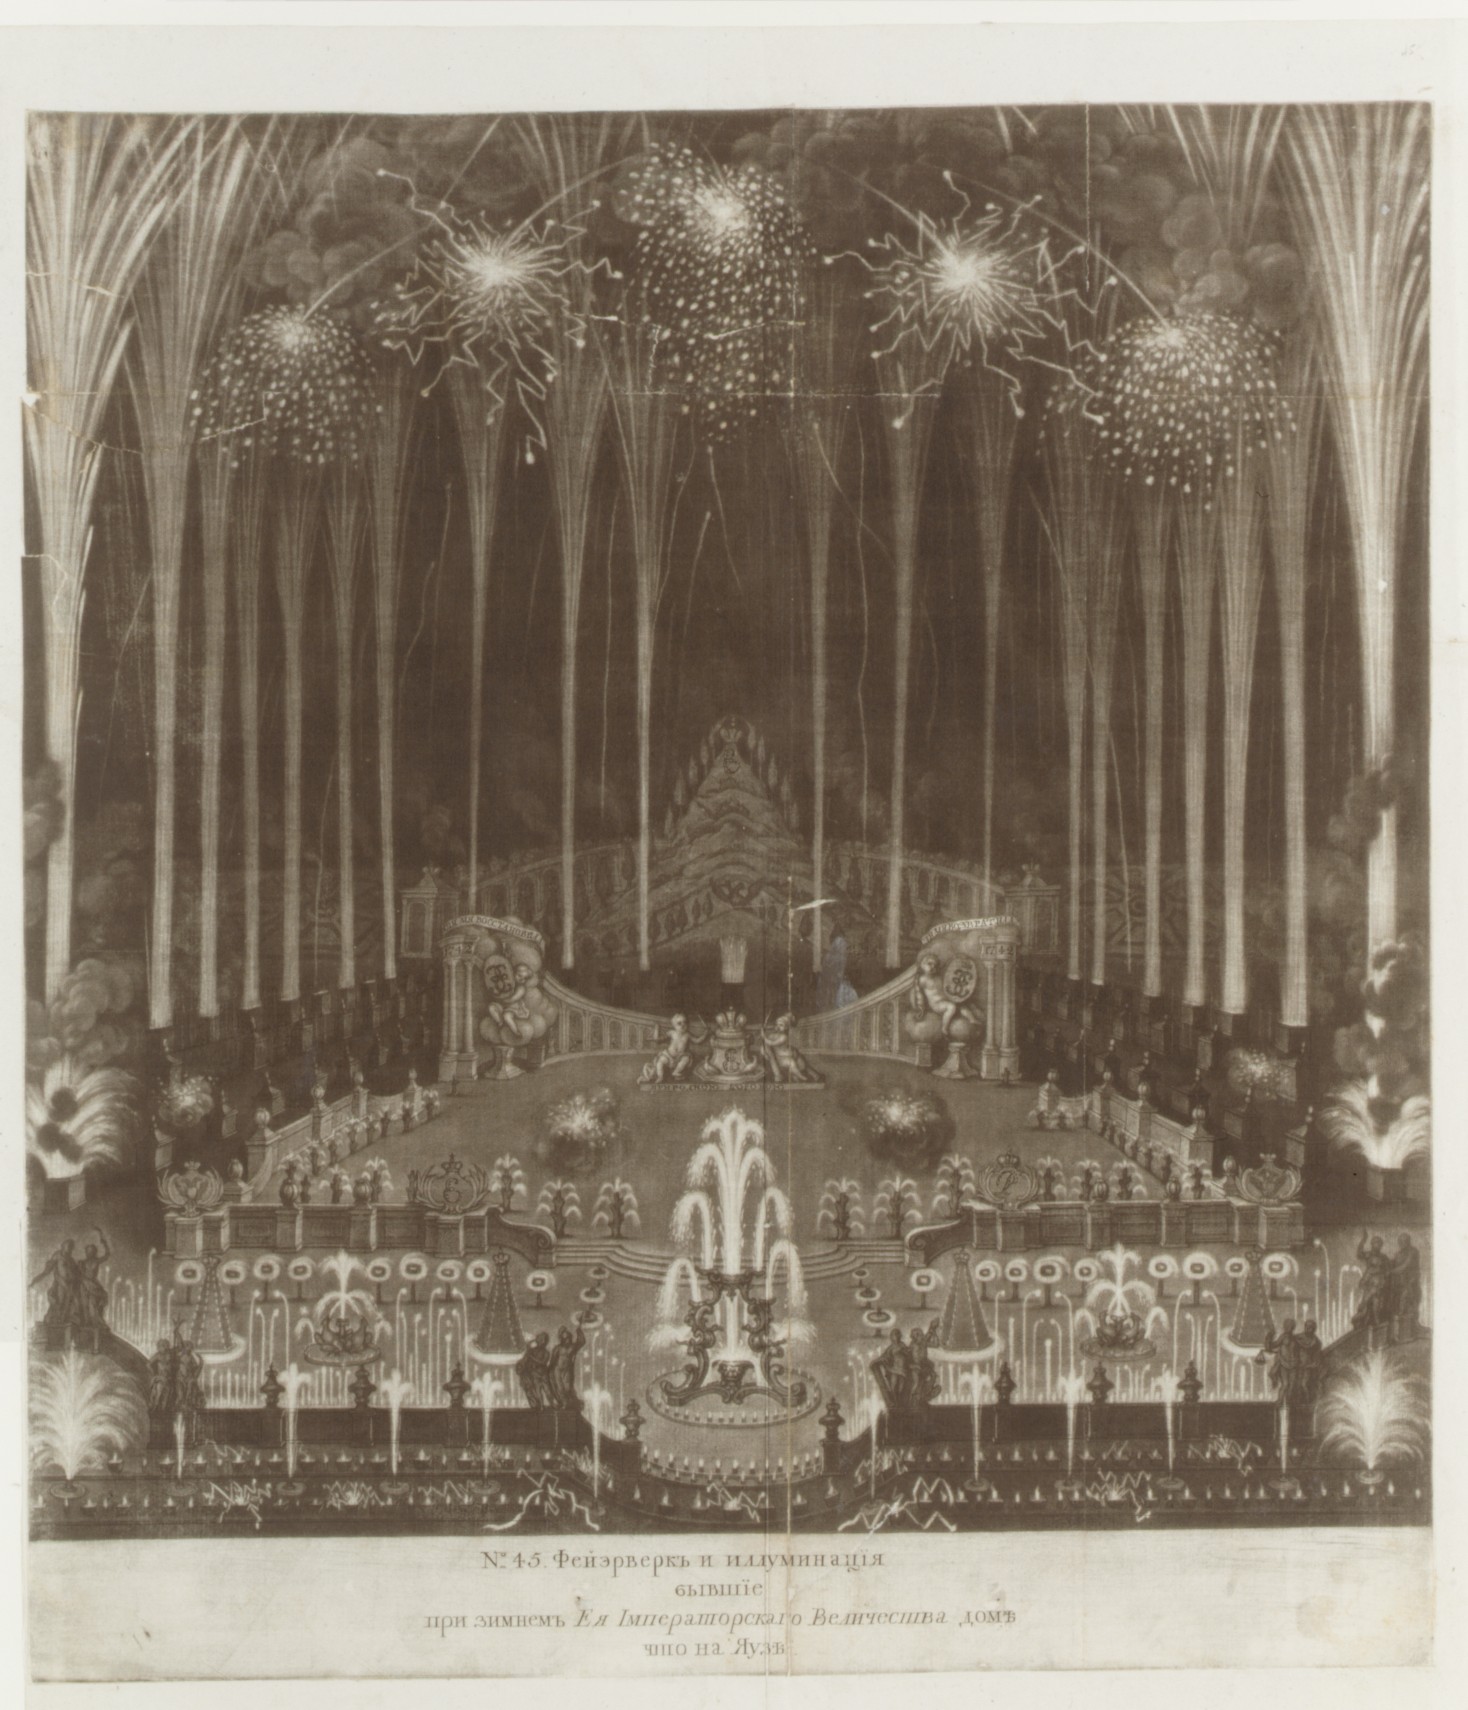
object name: print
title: Coronation of Czarina Elizabeth, Moscow, April 25, 1742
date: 1742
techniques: mezzotint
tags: fireworks,ceremony